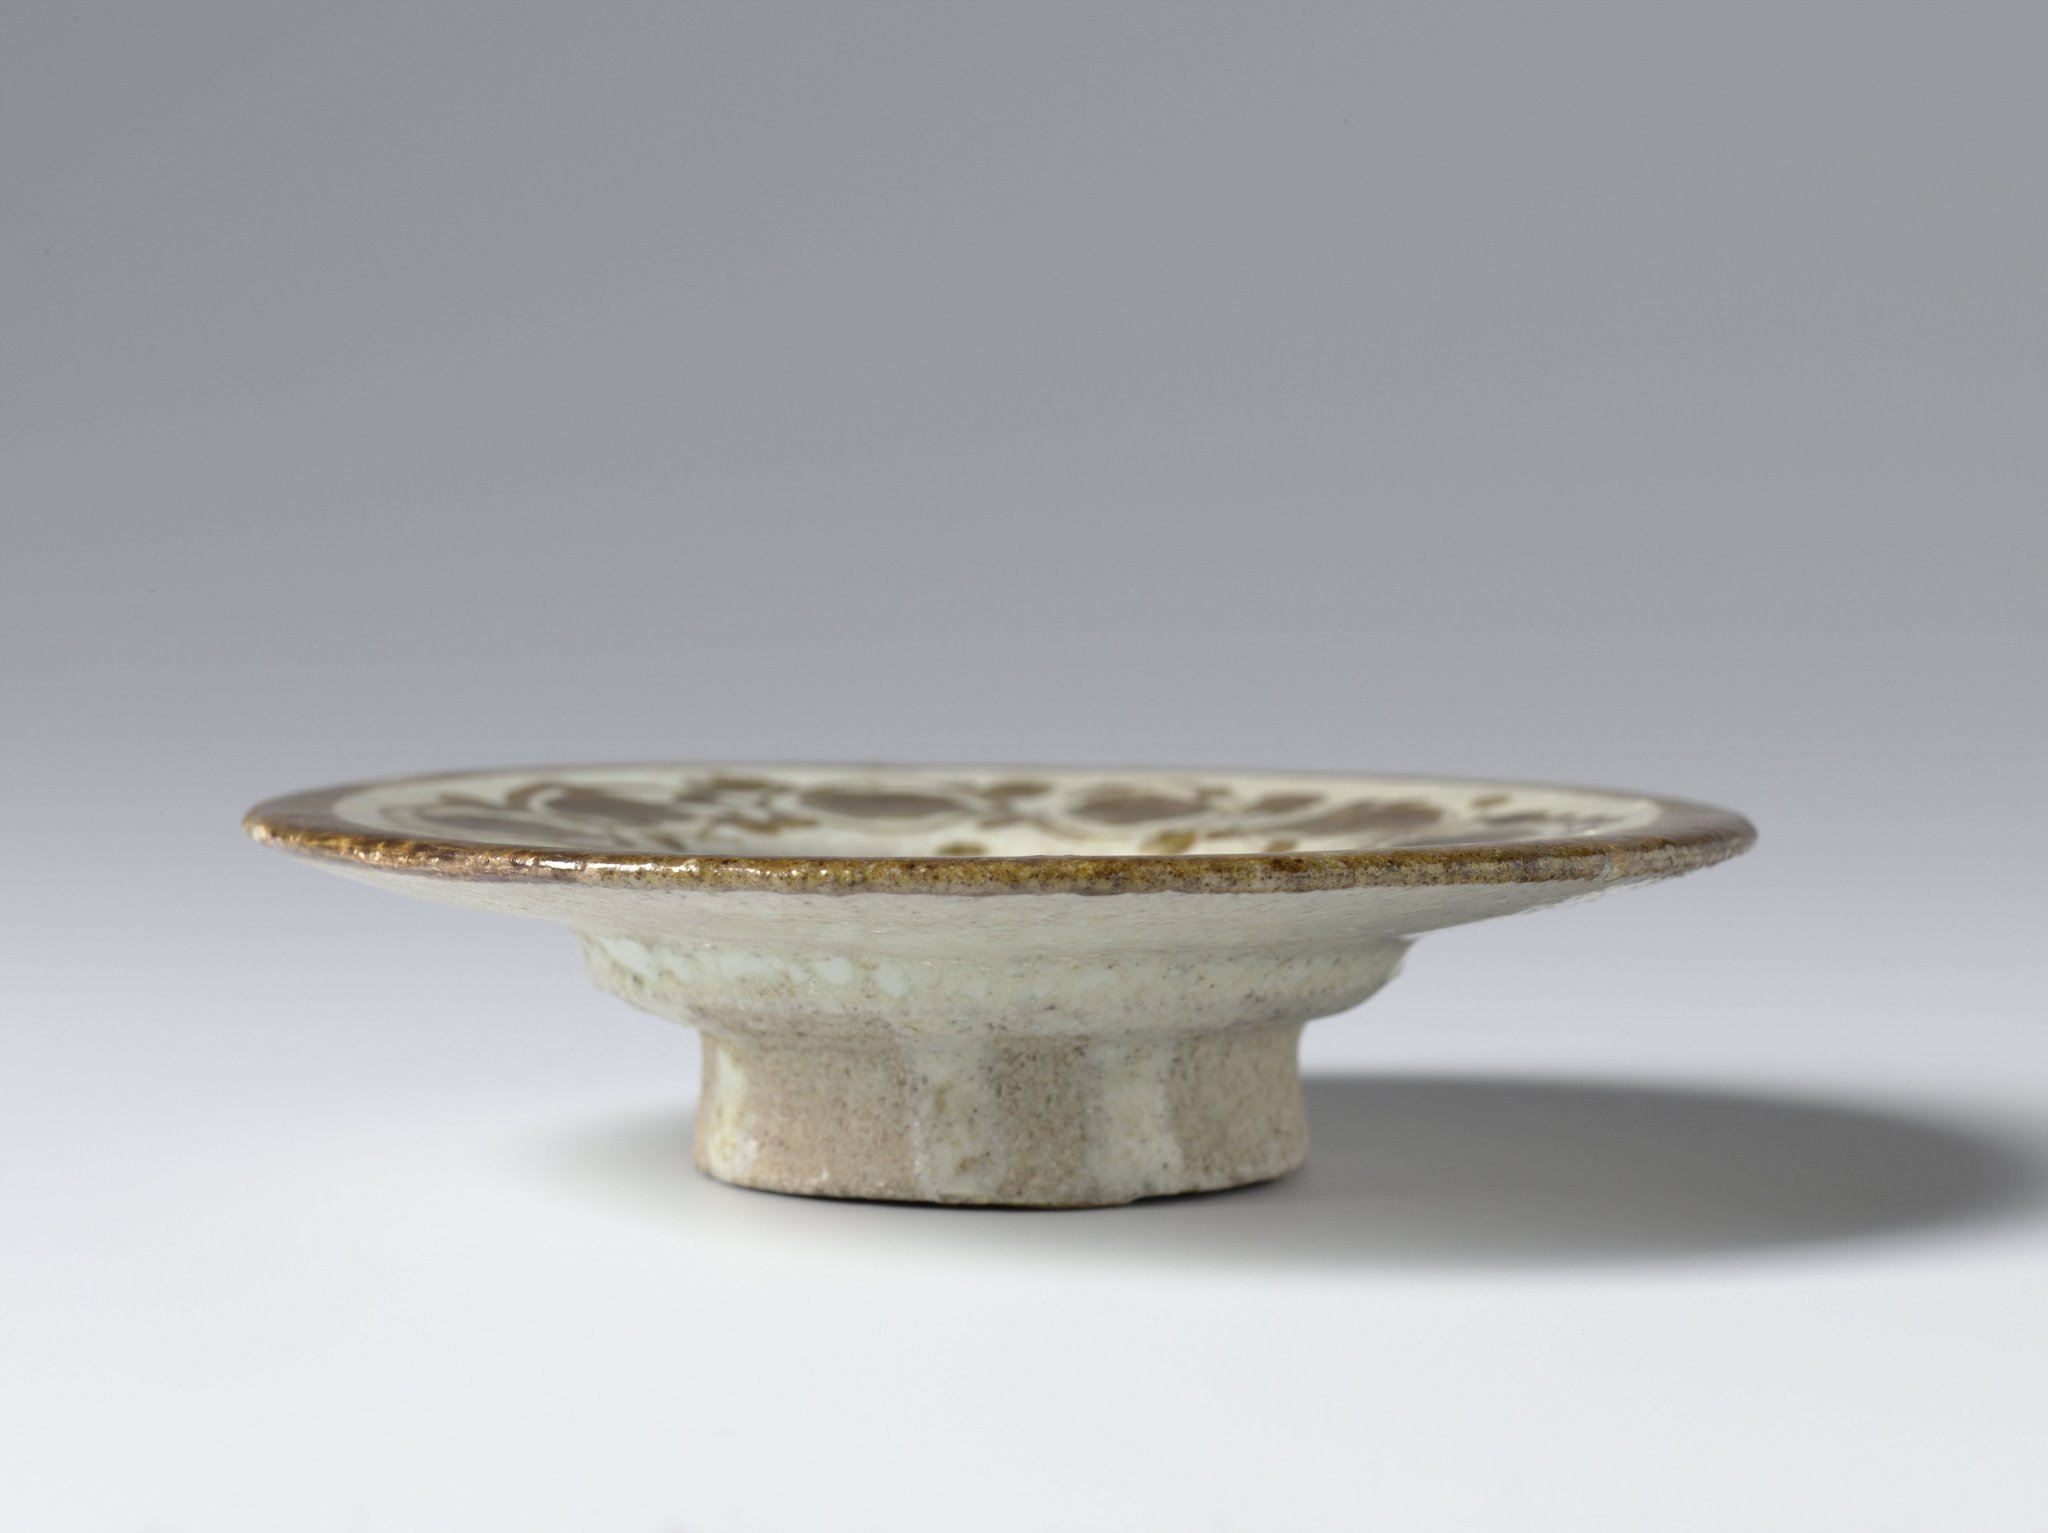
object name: bowl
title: Bowl with scrolls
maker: Anonymous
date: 1170-1200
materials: earthenware, glaze, luster, paint, quartz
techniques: firing, turning, vitrification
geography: kashan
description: Kom van kwarts-fritgoed met een opaak wit tin-lood-alkaliglazuur waarop een decor met ranken van luster.